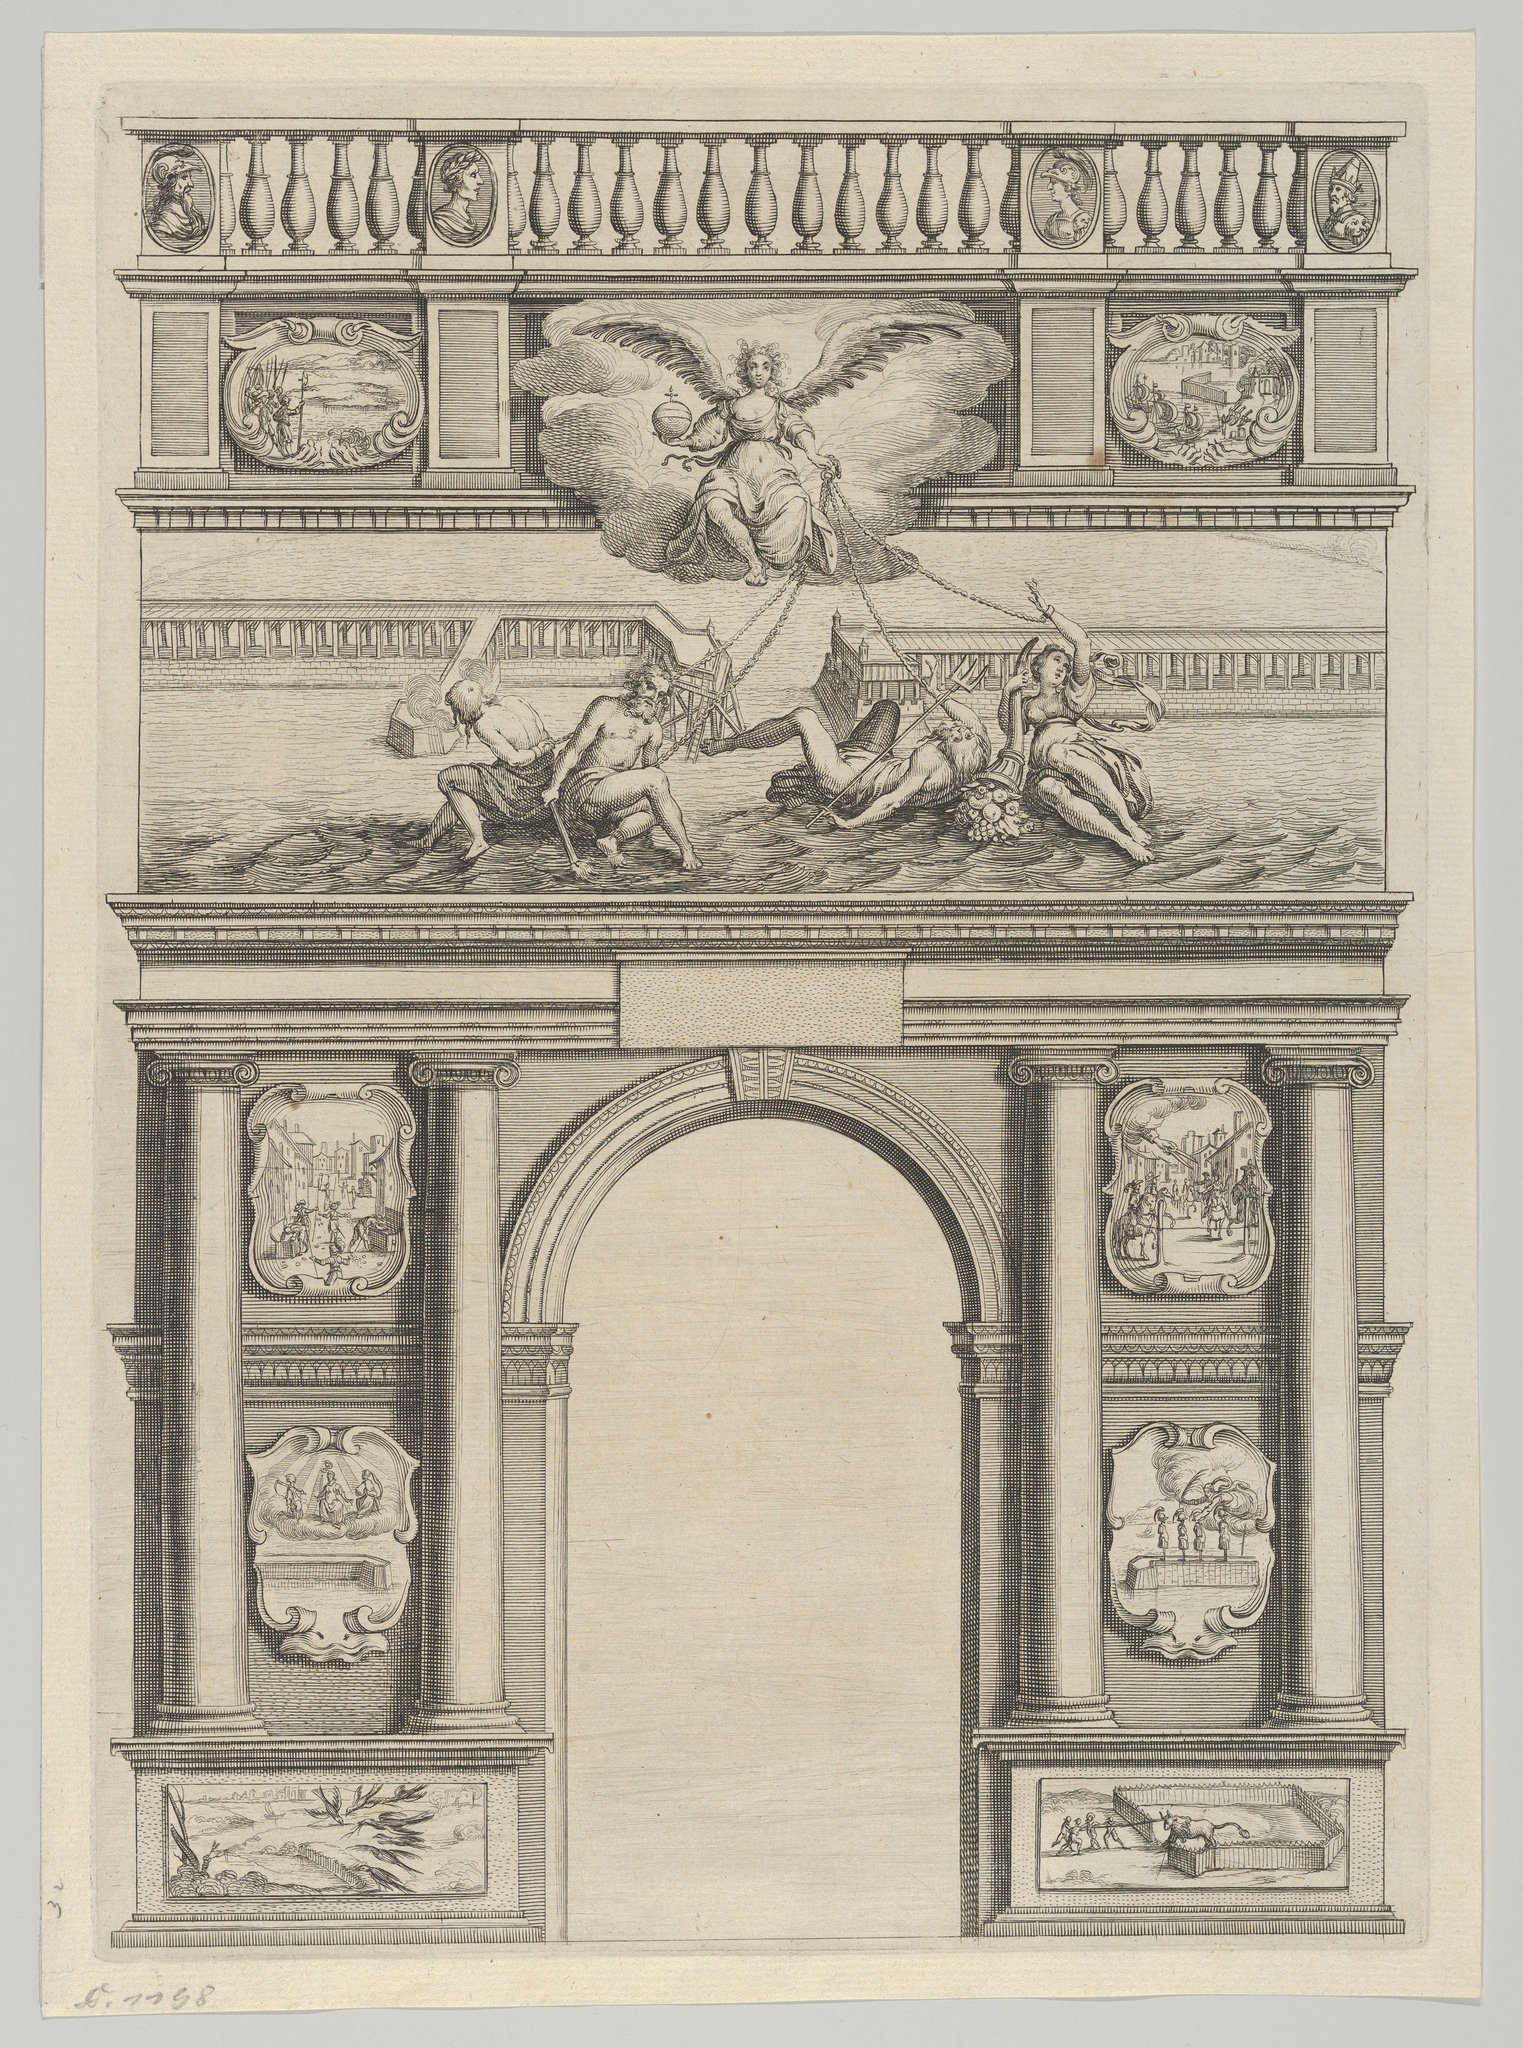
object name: print, fete, ornament architecture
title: Triumphal arch, from 'Éloges et discours sur la triomphante réception du Roy en sa ville de Paris ...' by Jean-Baptiste de Machault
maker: melchior tavernier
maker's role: artist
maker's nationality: french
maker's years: 1564-1641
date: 1629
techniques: etching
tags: architecture,arches